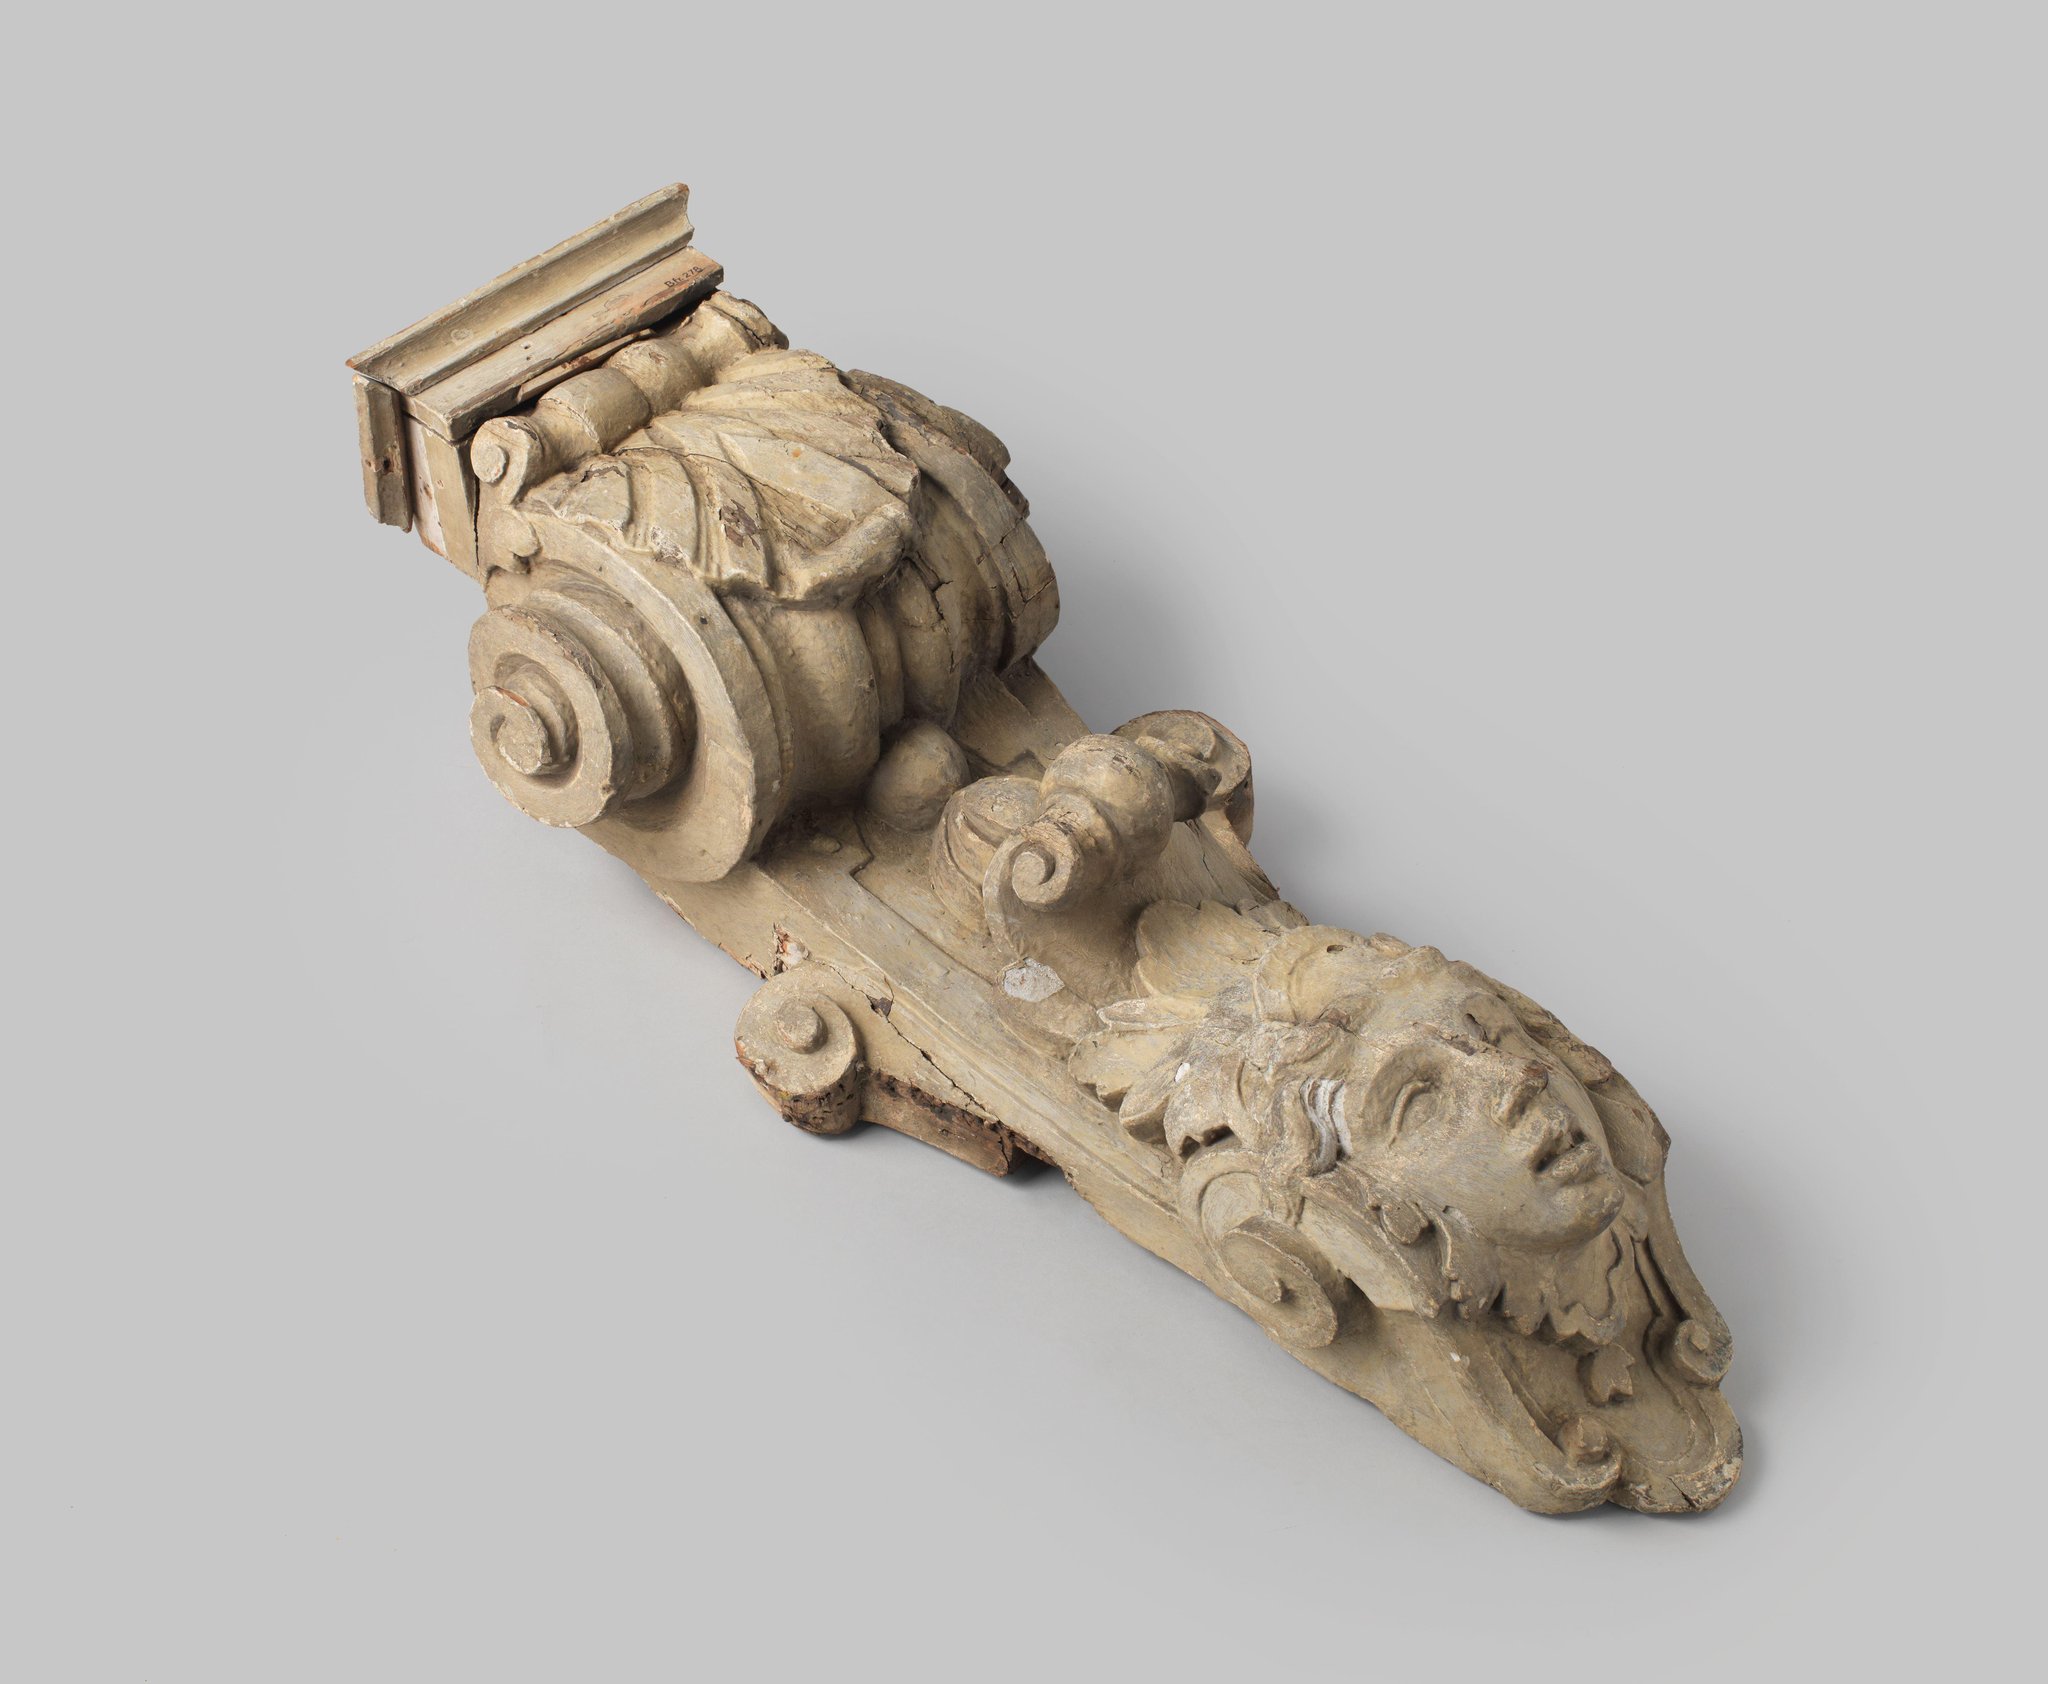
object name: console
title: Console, uitgevoerd in Lodewijk-XIV-stijl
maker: Anonymous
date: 1400-1950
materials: paint, wood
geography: netherlands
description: Een grenenhouten console, uitgevoerd in Lodewijk-XIV-stijl.